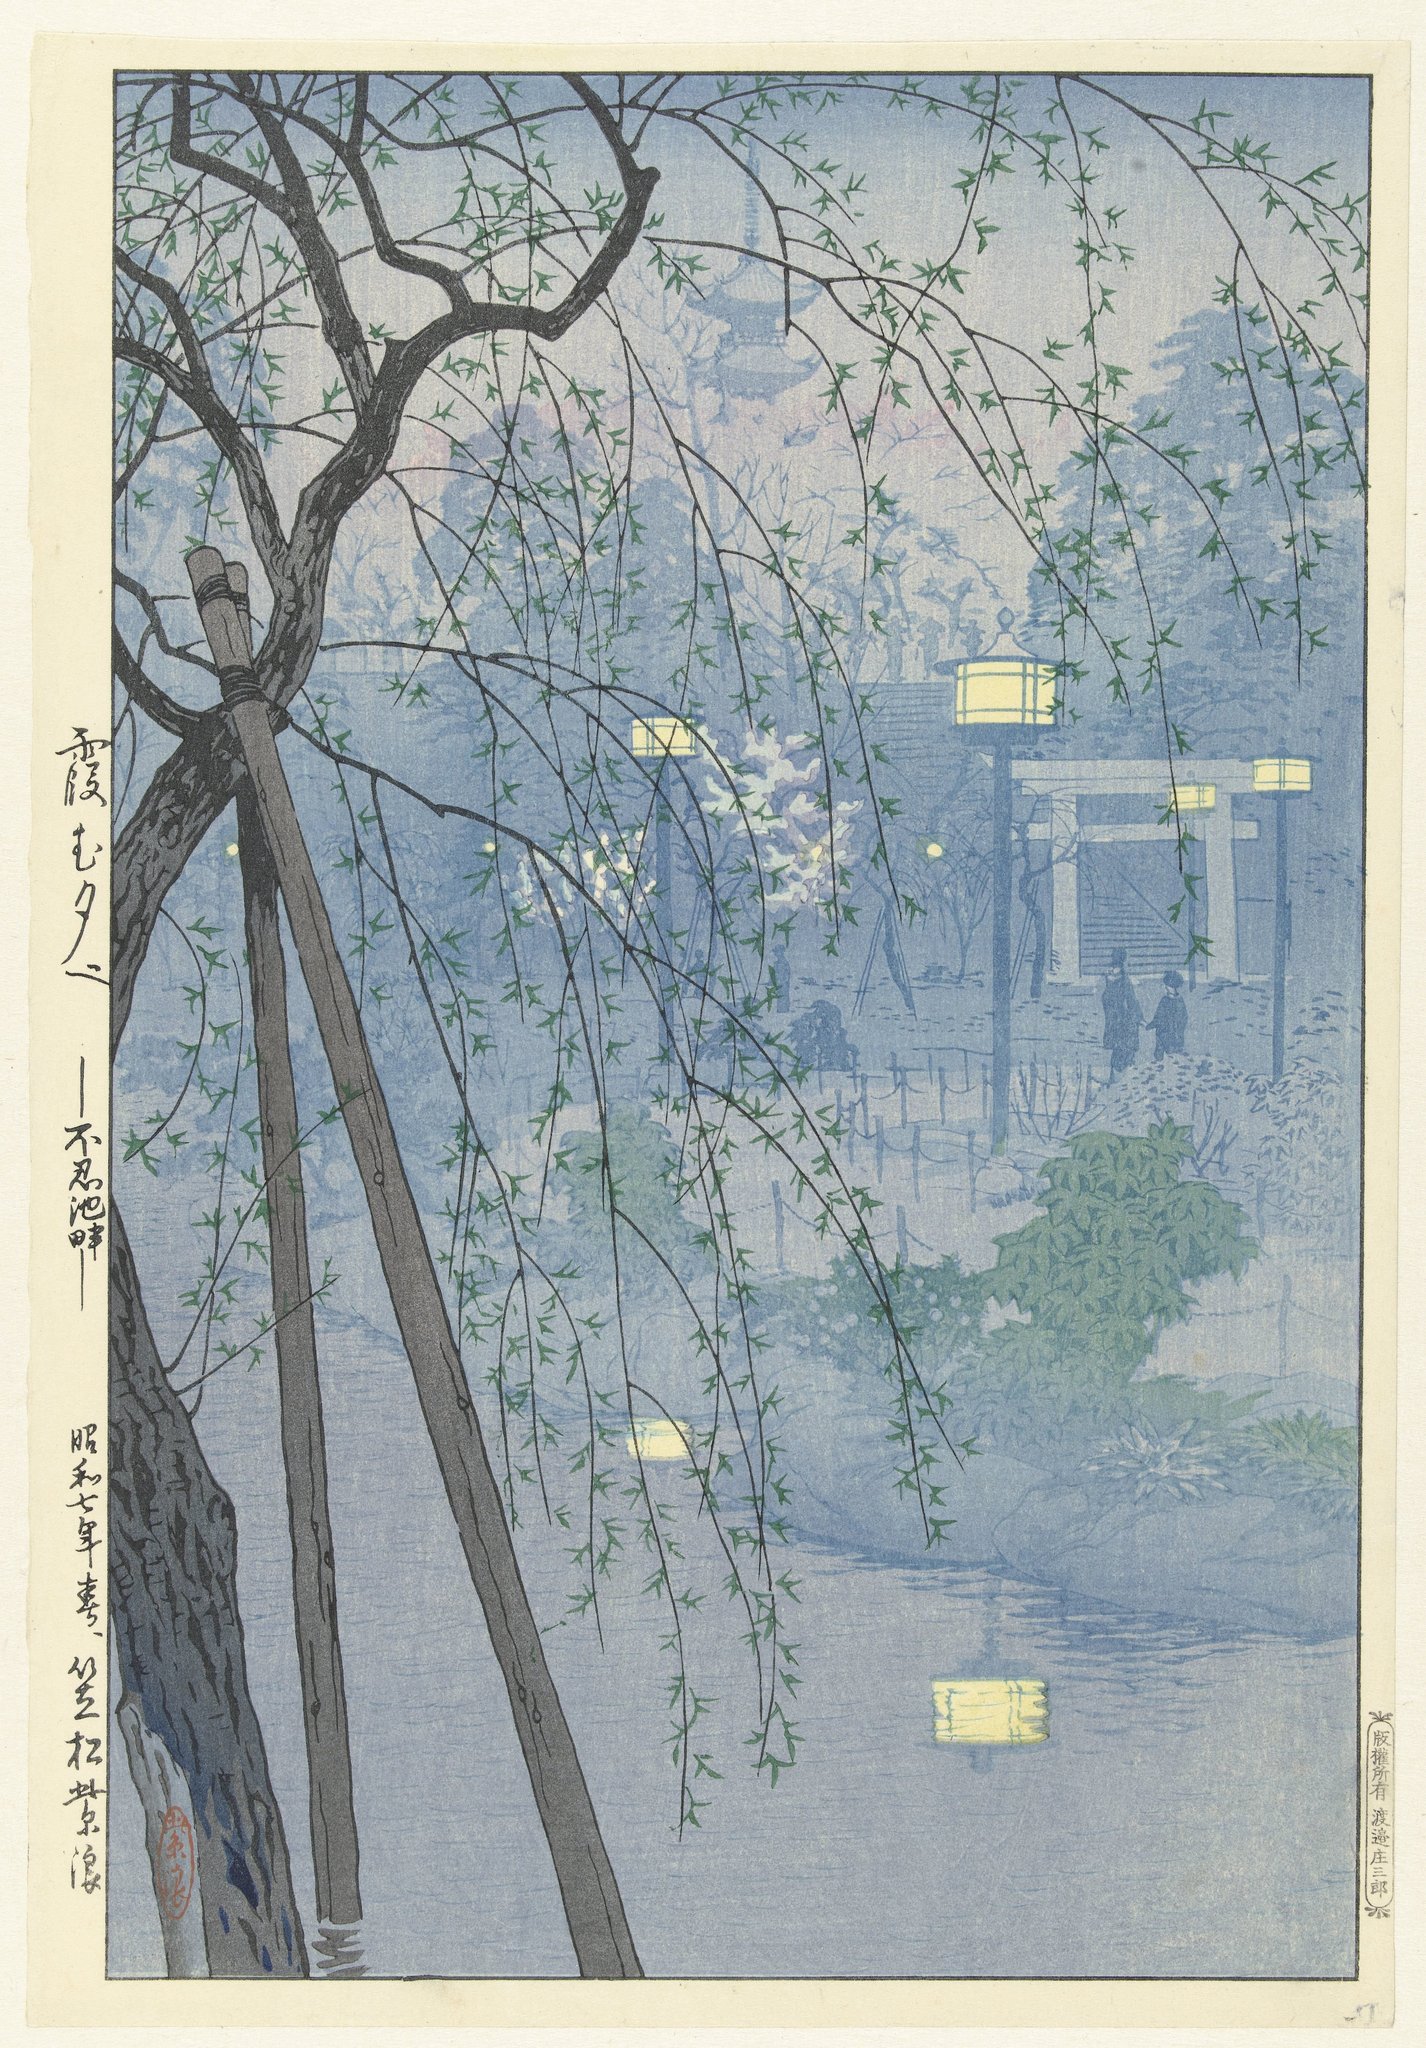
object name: print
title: Kasumu yube Shinobazu chihan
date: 1932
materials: paper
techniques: woodcut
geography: japan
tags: water course, lighting; lamps, public gardens, park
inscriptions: collector's mark: Lugt 2760, collector's mark: Lugt 2228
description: Het Ueno park tijdens een nevelige avond. Water op de voorgrond, in de achtergrond brandende lantaarns, wandelende mensen en een pagode.